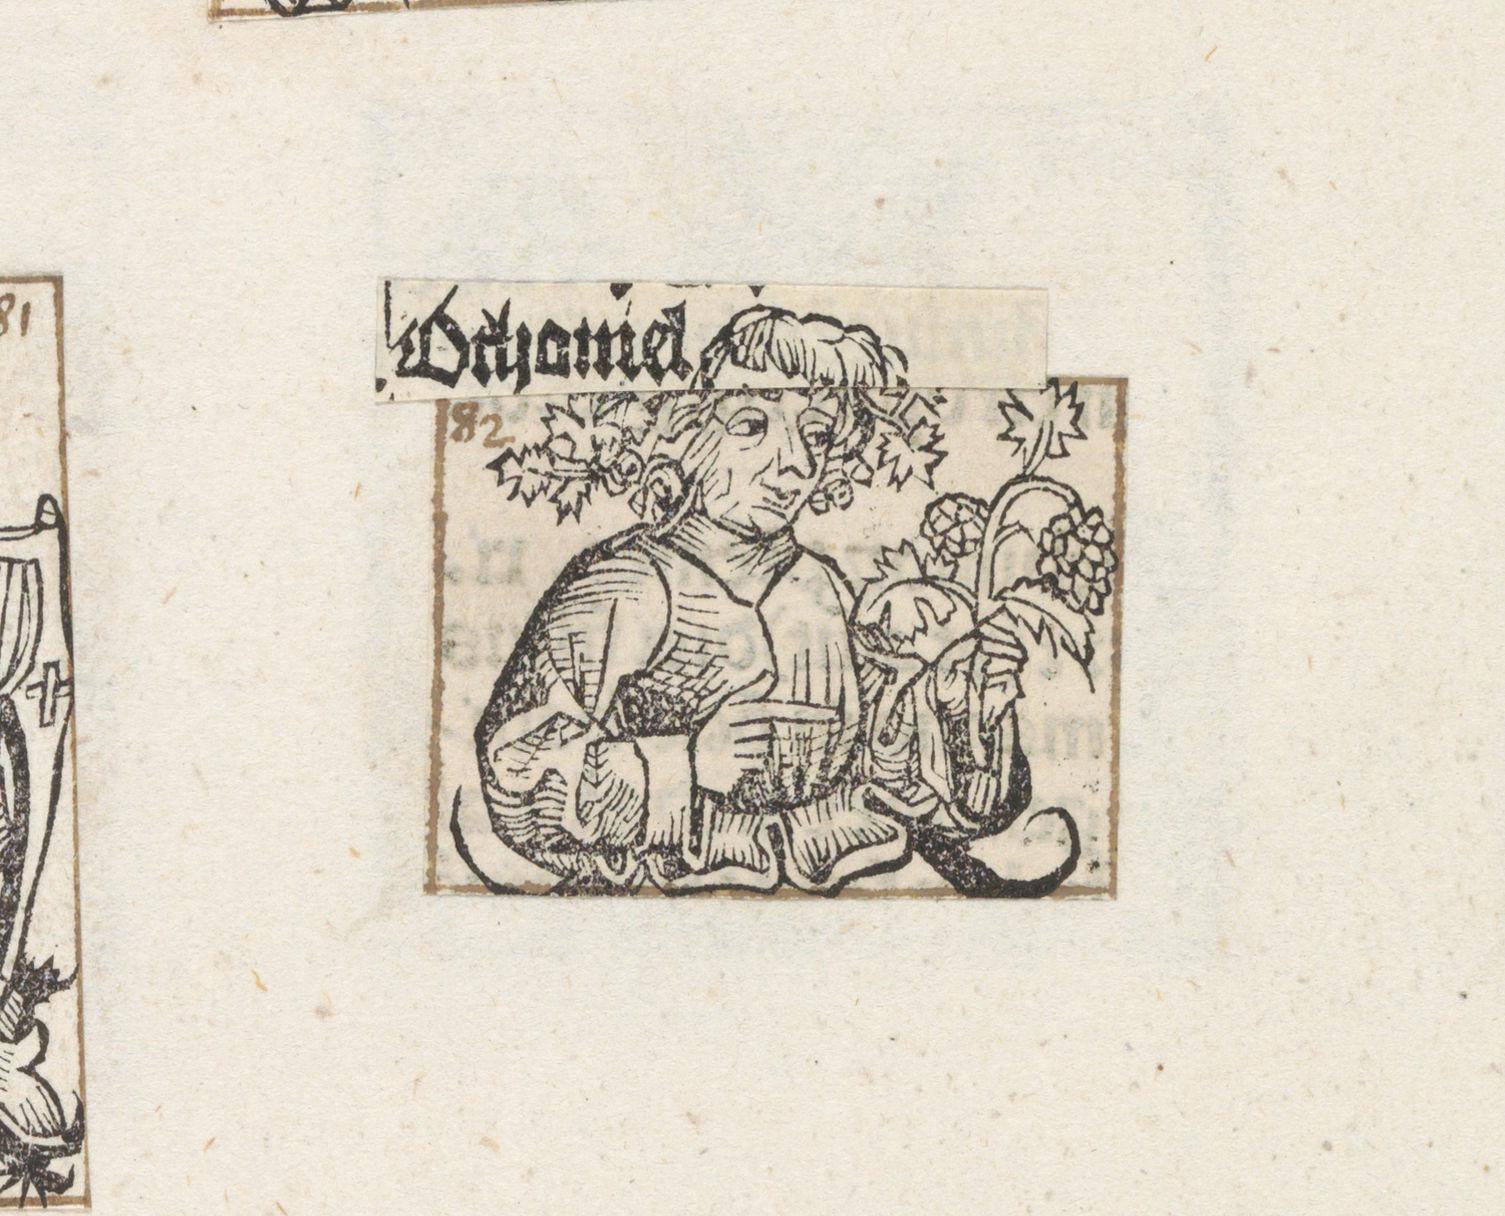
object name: album leaf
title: Bacchus of Otniël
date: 1493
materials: paper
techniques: letterpress printing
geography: nuremberg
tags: (story of) bacchus (dionysus), liber, persons from the old testament (not in biblical context, nor occurring in legendary/historical extensions included in division 71)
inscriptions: inscription: ‘82’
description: Voorstelling in twee delen. Een bloemkelk met een man. In zijn handen heeft hij een druiventak. Het betreft de afbeelding van Bacchus in de Liber Chronicarum. De bijgeplakte titel identificeert hem echter als Otniël, de eerste rechter van Israël. De prent maakt deel uit van een album.